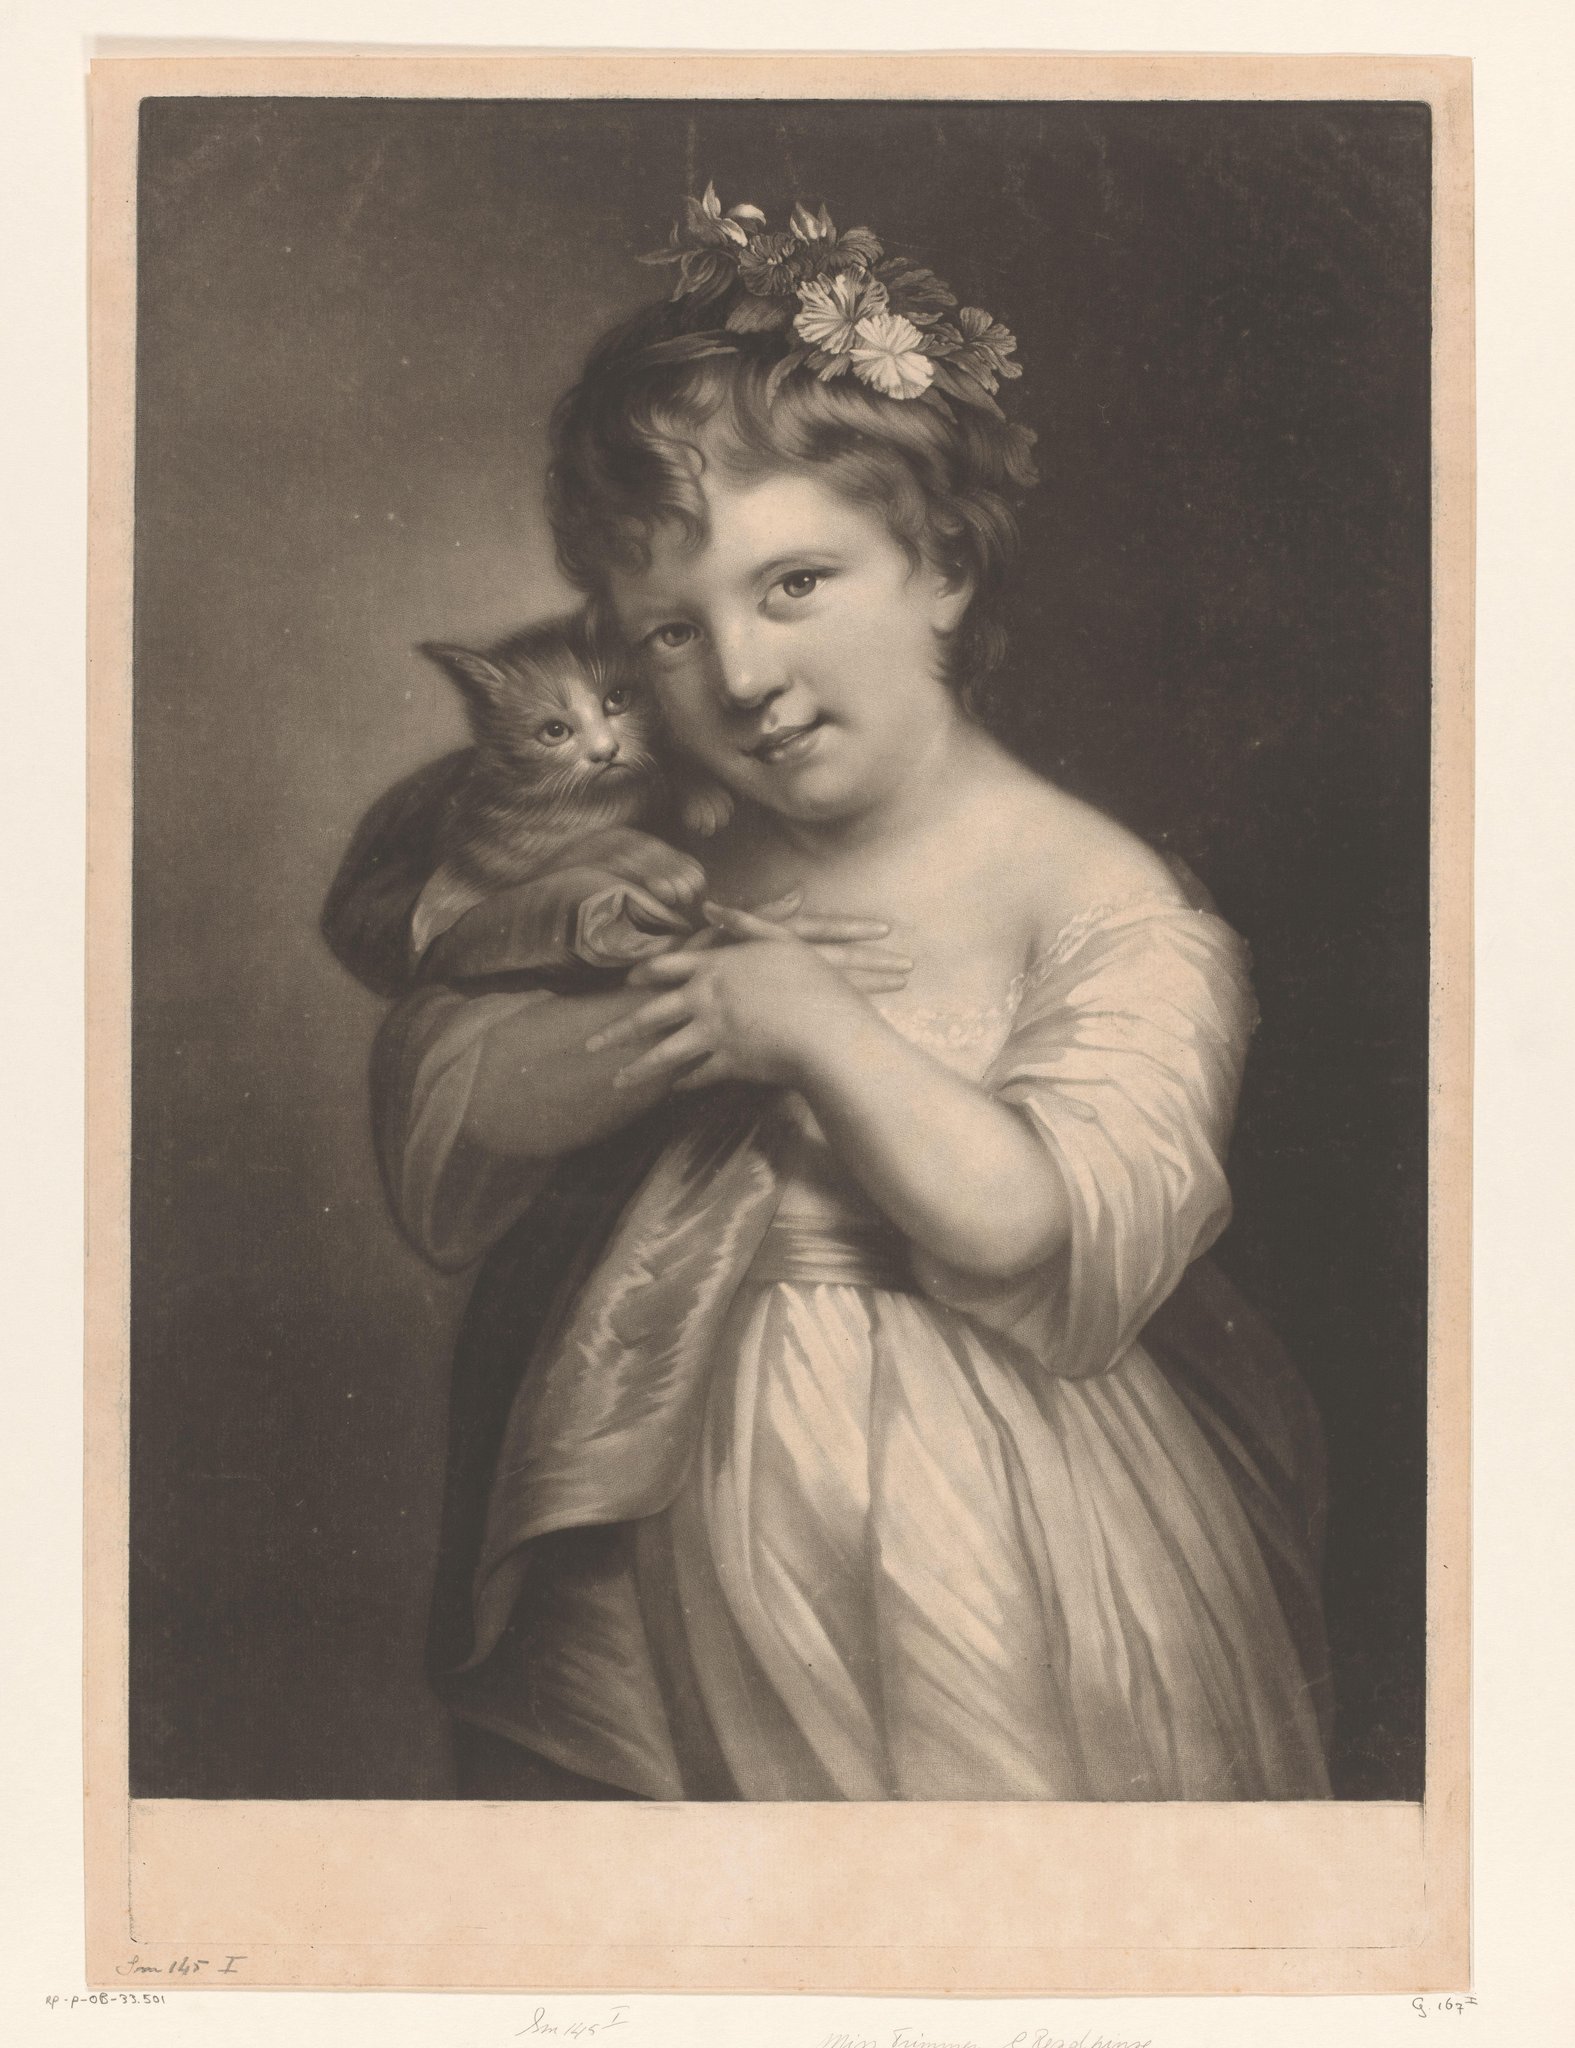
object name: print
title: Portret van een vrouw, mogelijk Charlotte Trimmer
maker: james watson (prentmaker)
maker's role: print maker, publisher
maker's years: 1740-1790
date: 1765-1770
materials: paper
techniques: mezzotint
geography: london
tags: flowers, cat, historical persons - bb - woman, girl (child between toddler and youth)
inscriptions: collector's mark: Lugt 240